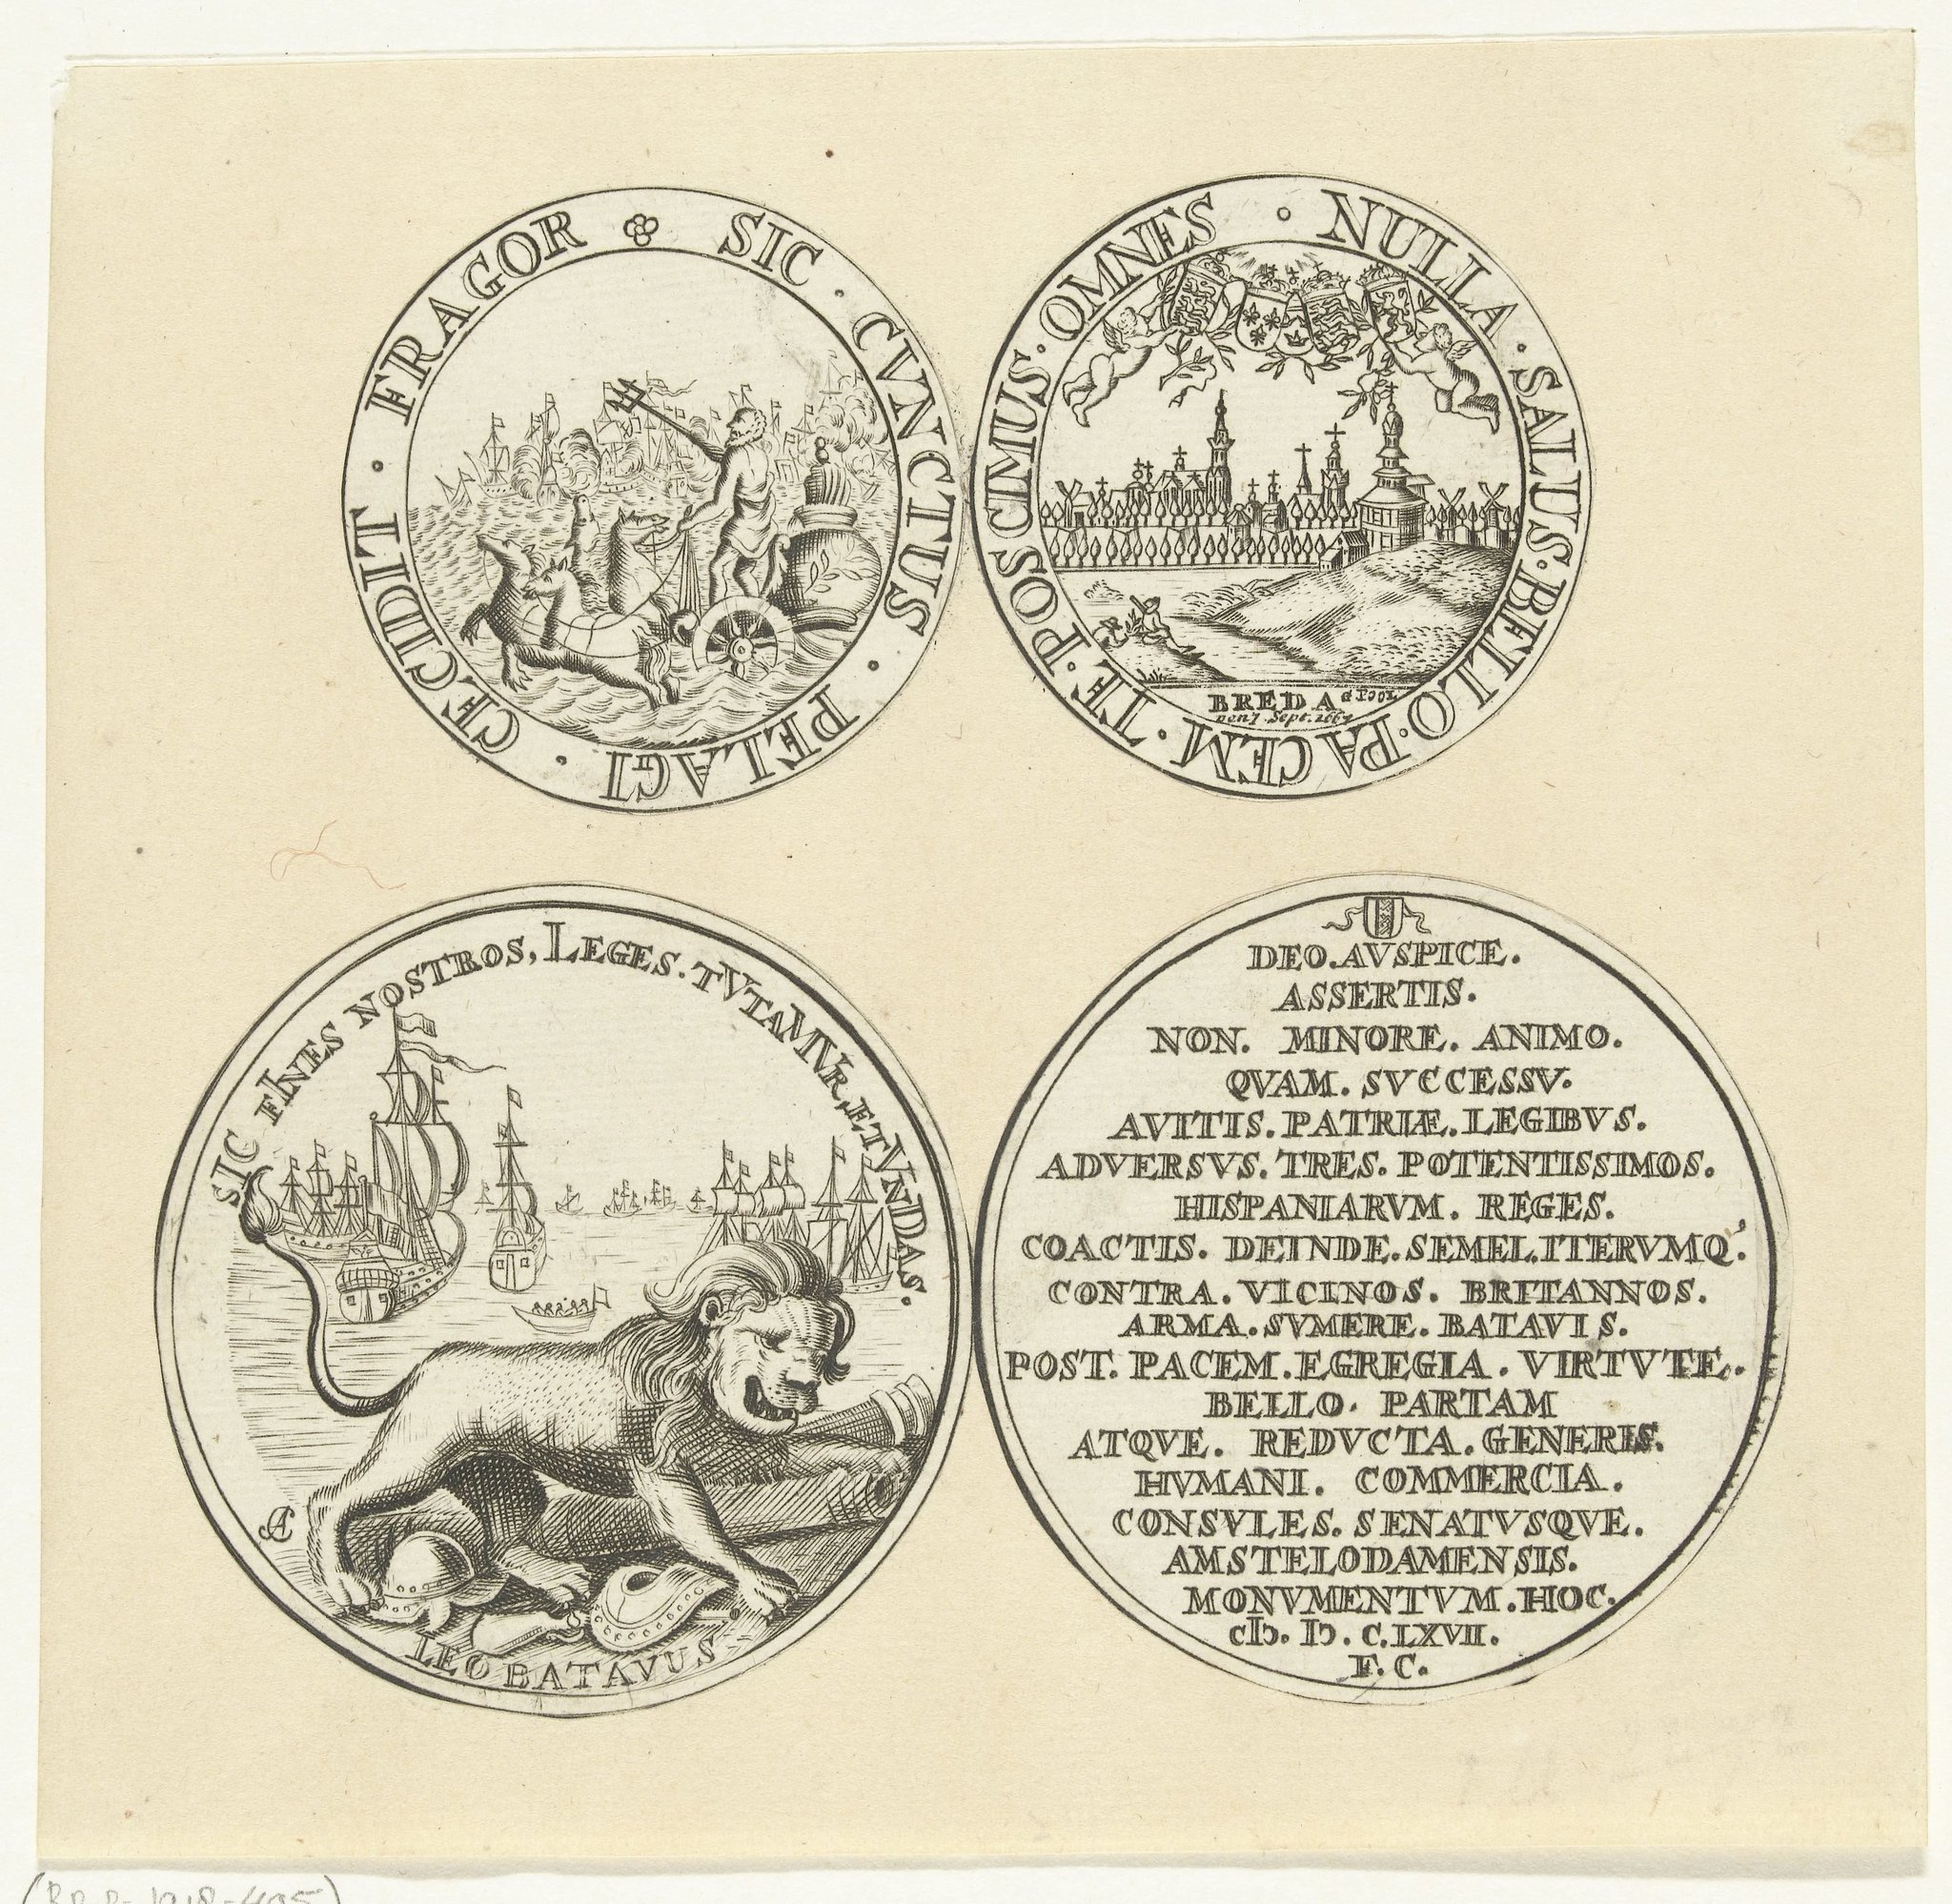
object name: print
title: Twee penningen op de Vrede te Breda, 1667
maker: Anonymous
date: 1700-1799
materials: paper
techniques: engraving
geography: northern netherlands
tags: medal (considered as a piece of sculpture, regardless of its specific function)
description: Zie de penningen in de collectie van het Rijksmuseum, Amsterdam: NG-VG-1-1025 en NG-VG-1-1016.